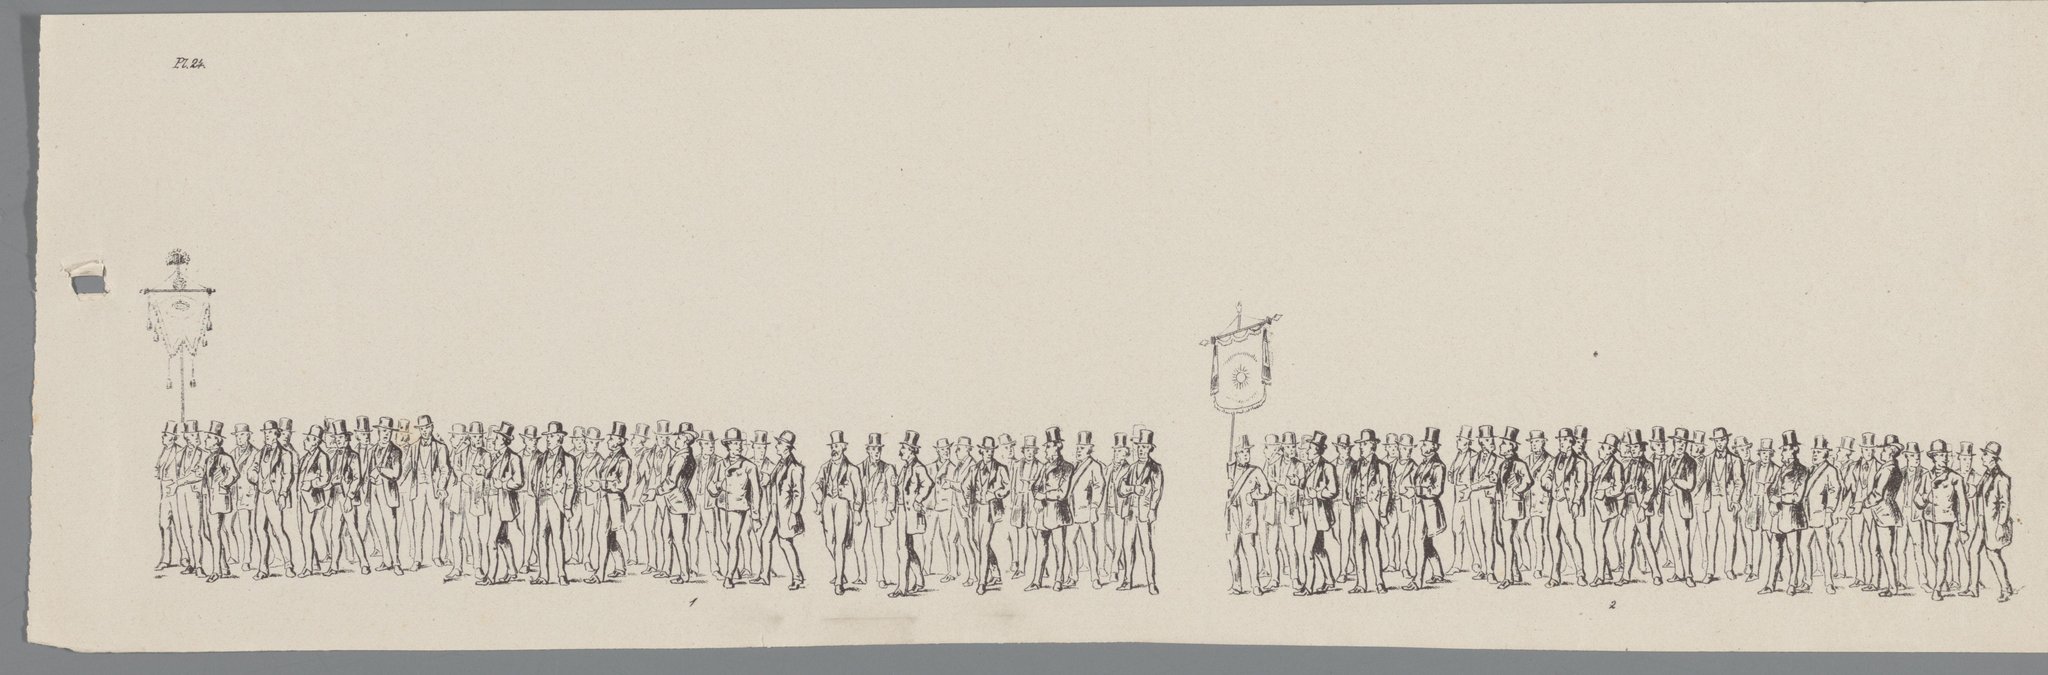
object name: print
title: Historische en Allegorische Optocht te Amsterdam. 12 mei 1874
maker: Anonymous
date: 1874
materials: paper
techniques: lithograph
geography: amsterdam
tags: brussels, willem iii (koning der nederlanden), public festivities at other royal events, not meant or mentioned above (+ parade, pageant, cavalcade ~ festive activities), modern professional organization, trade union, amsterdam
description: Plaat nr. 23 met het laatste deel van de optocht met leden van de verschillende vakverenigingen. Onderdeel van een serie van 24 platen van de gekostumeerde historische en allegorische optocht gehouden te Amsterdam op 12 mei 1874, als onderdeel van de feestelijkheden tijdens de viering van het 25-jarige regeringsjubileum van koning Willem III.